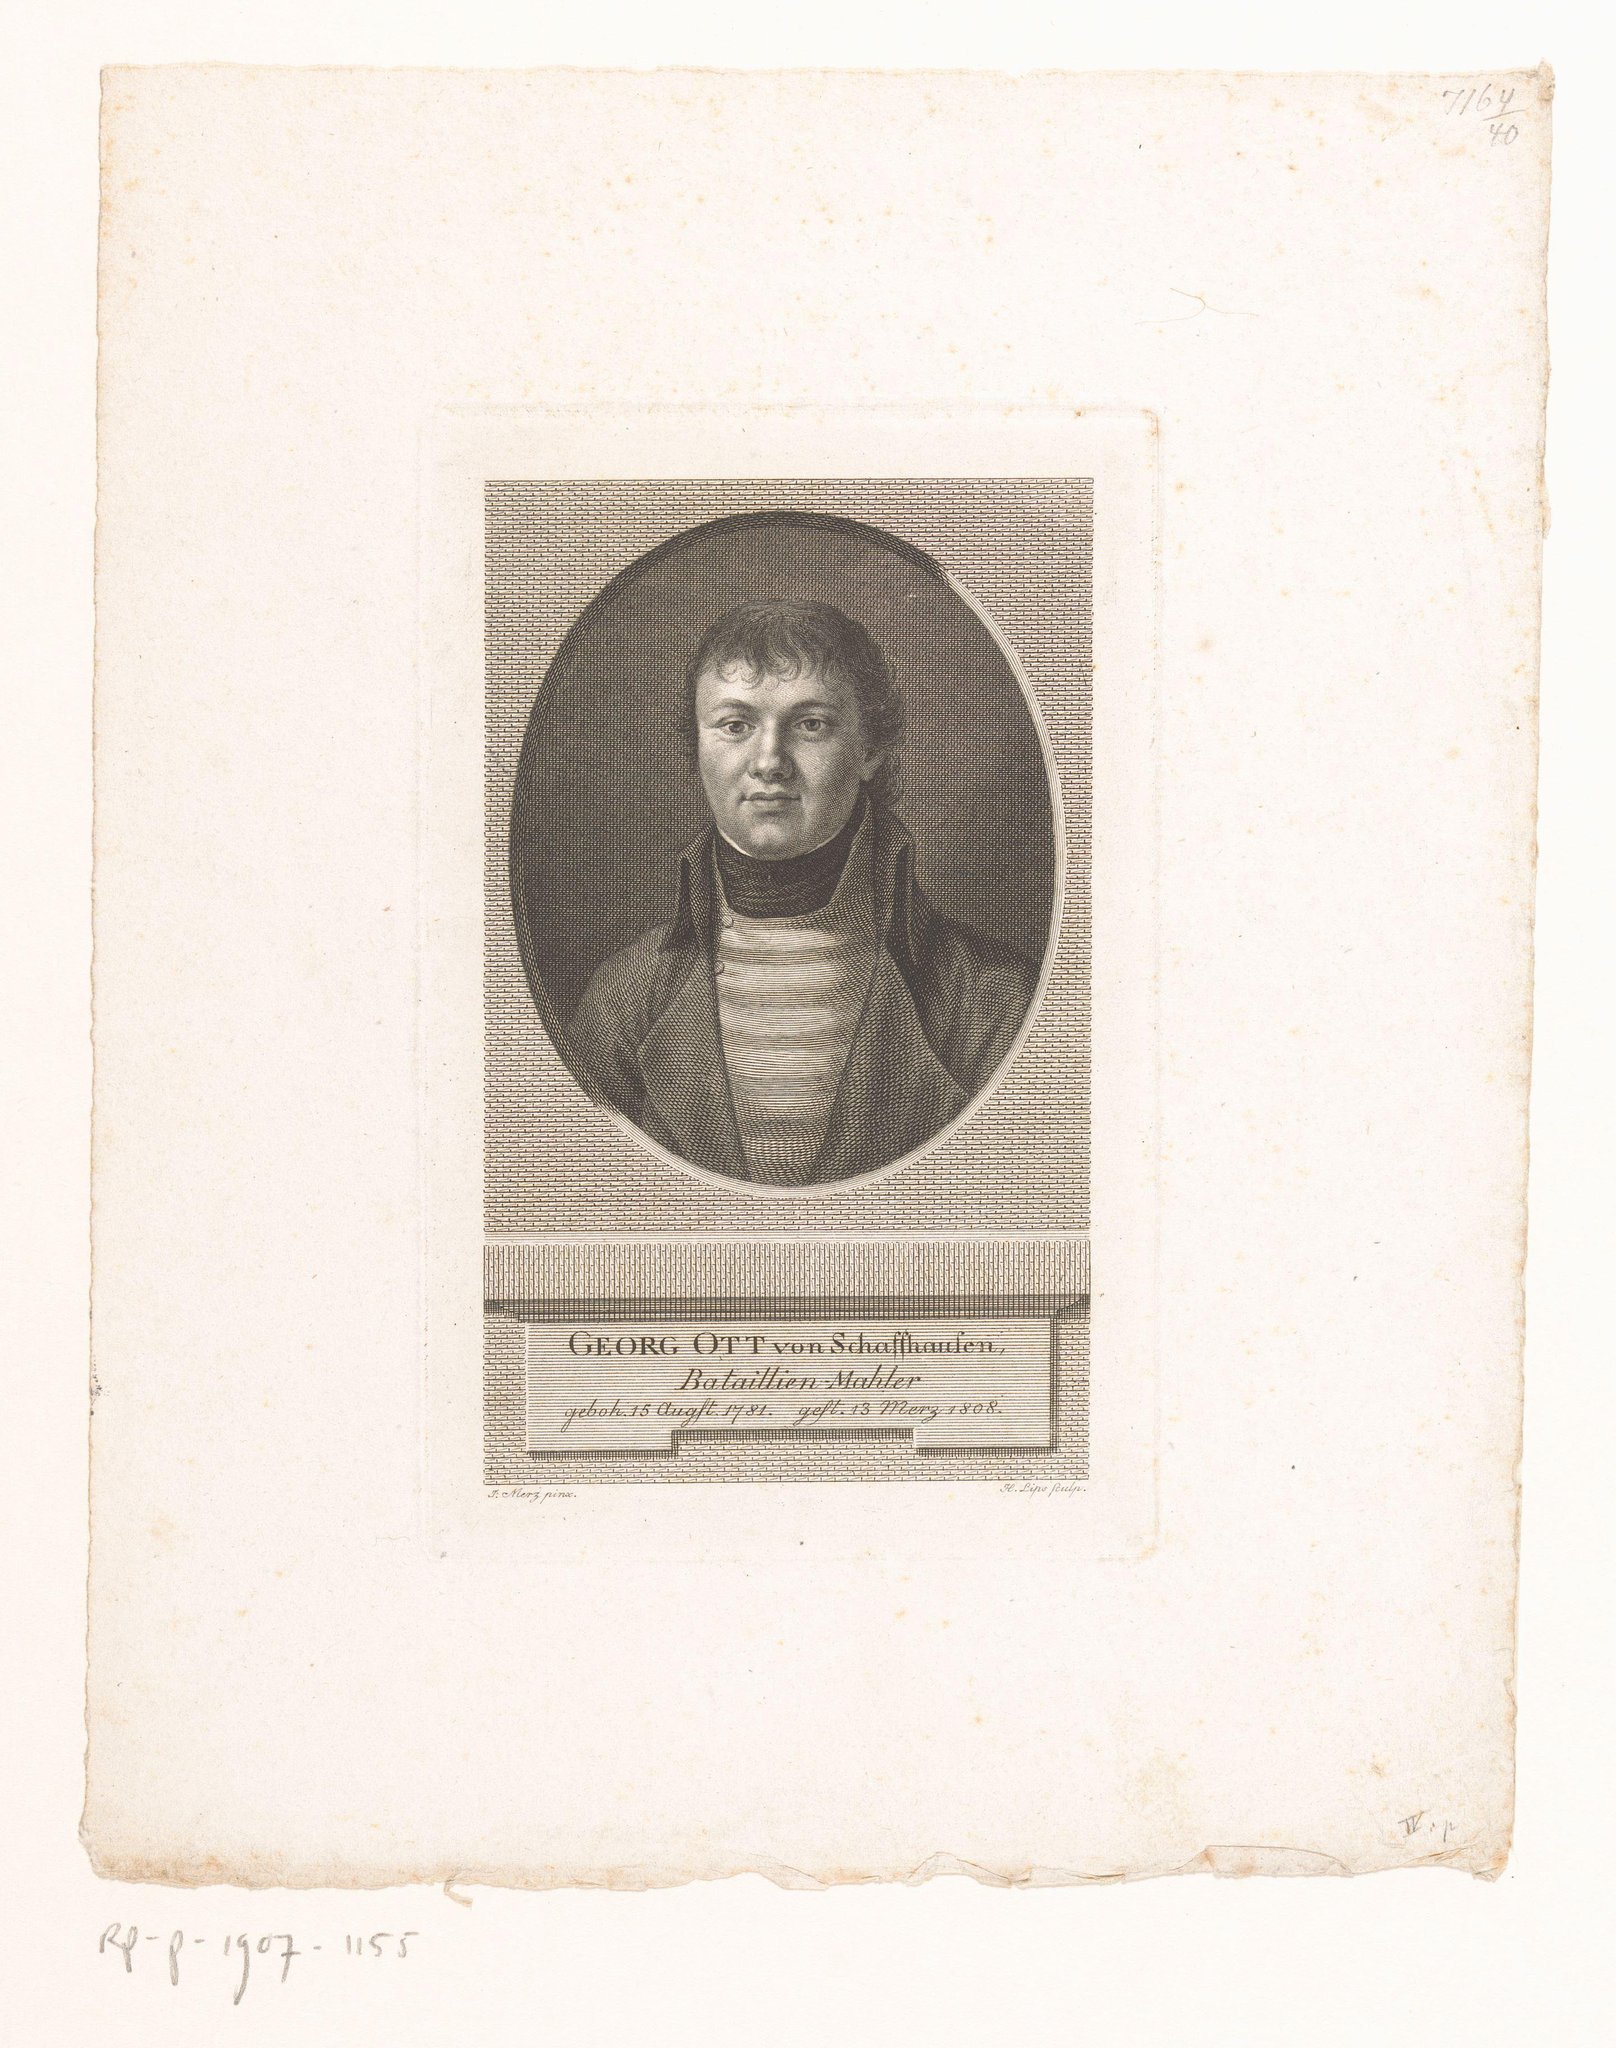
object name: print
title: Portret van Georg Ott von Schaffhausen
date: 1768-1817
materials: paper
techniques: engraving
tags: historical persons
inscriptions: collector's mark: Lugt 2228